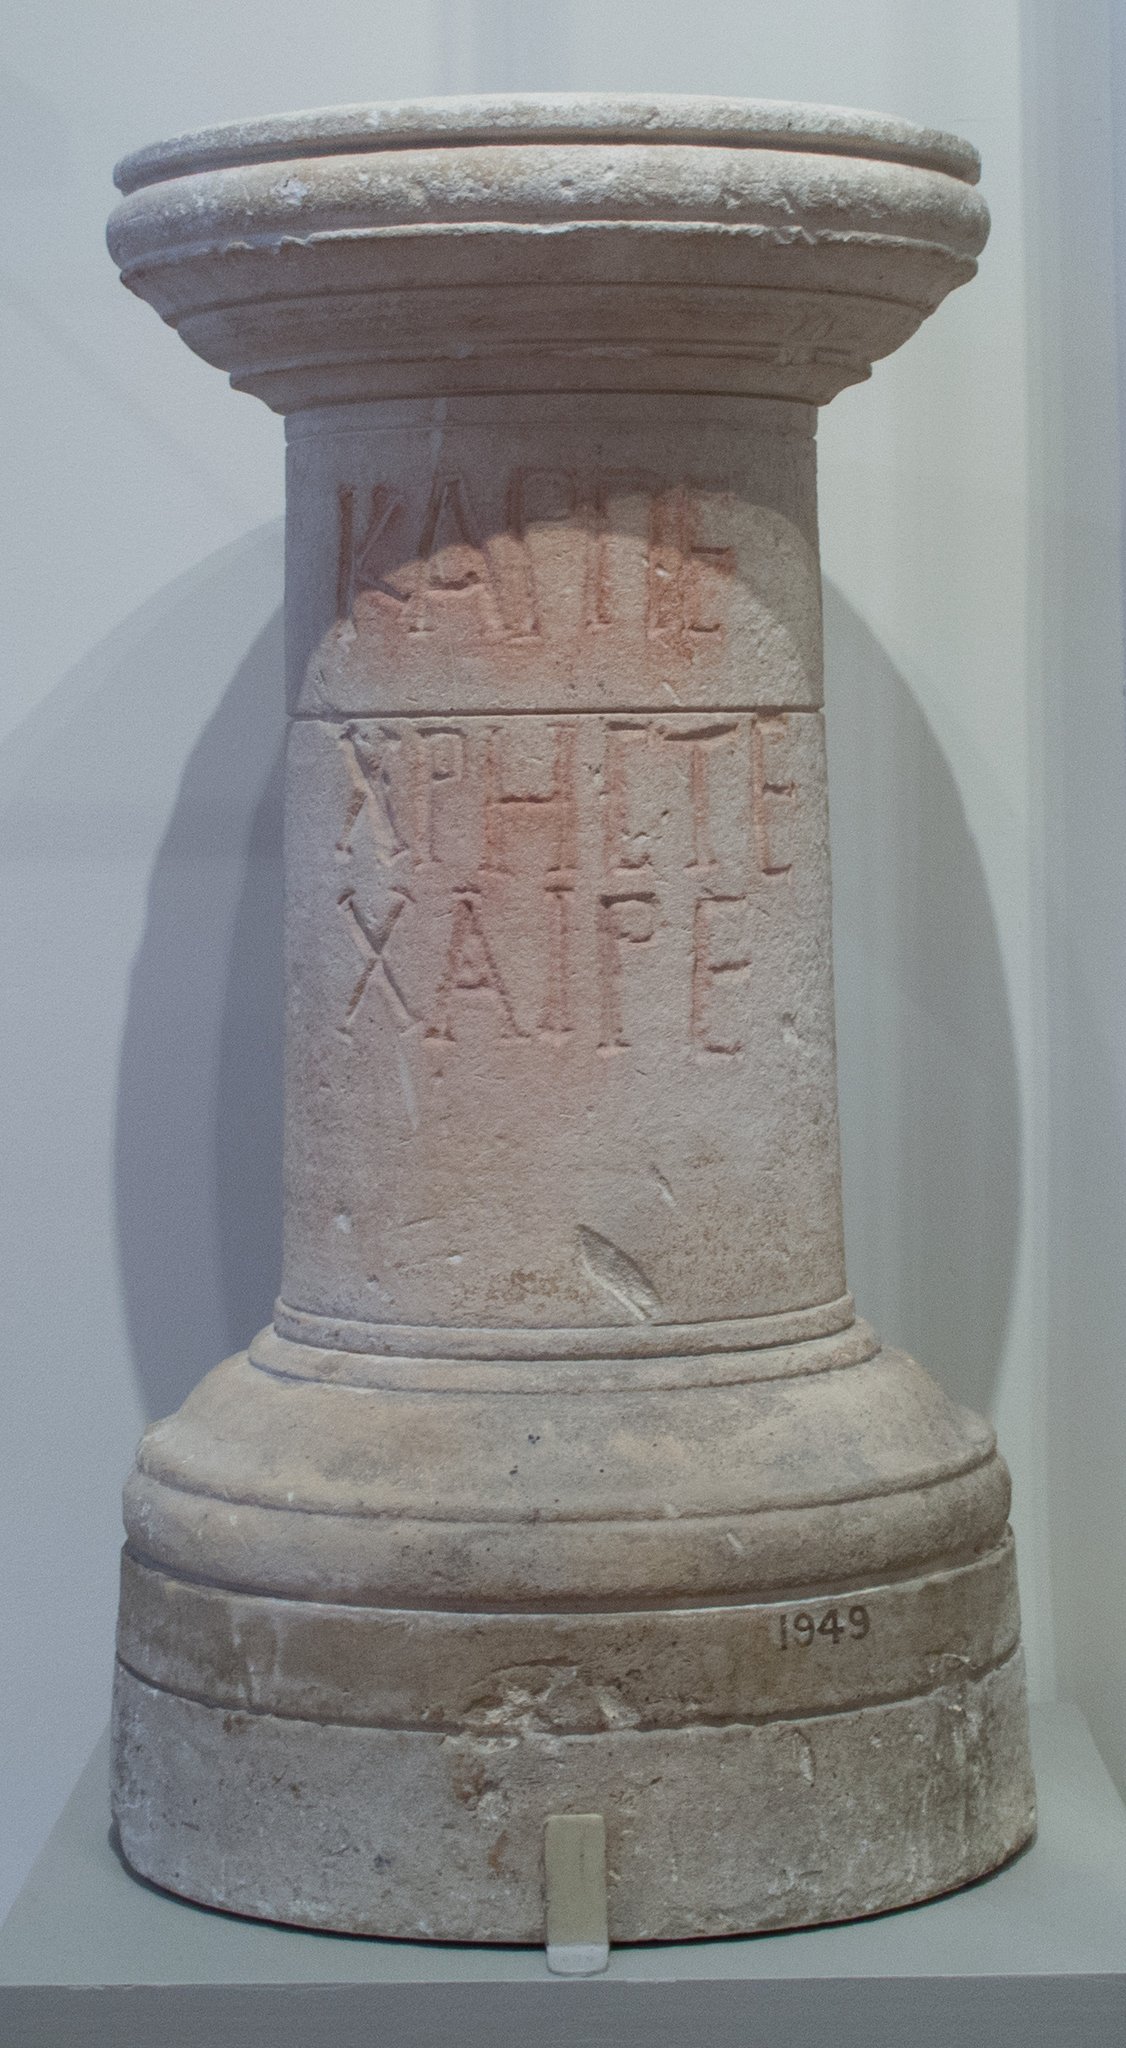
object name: cippus of karpos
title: Limestone funerary cippus (tomb marker)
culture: roman, cypriot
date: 101-300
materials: limestone